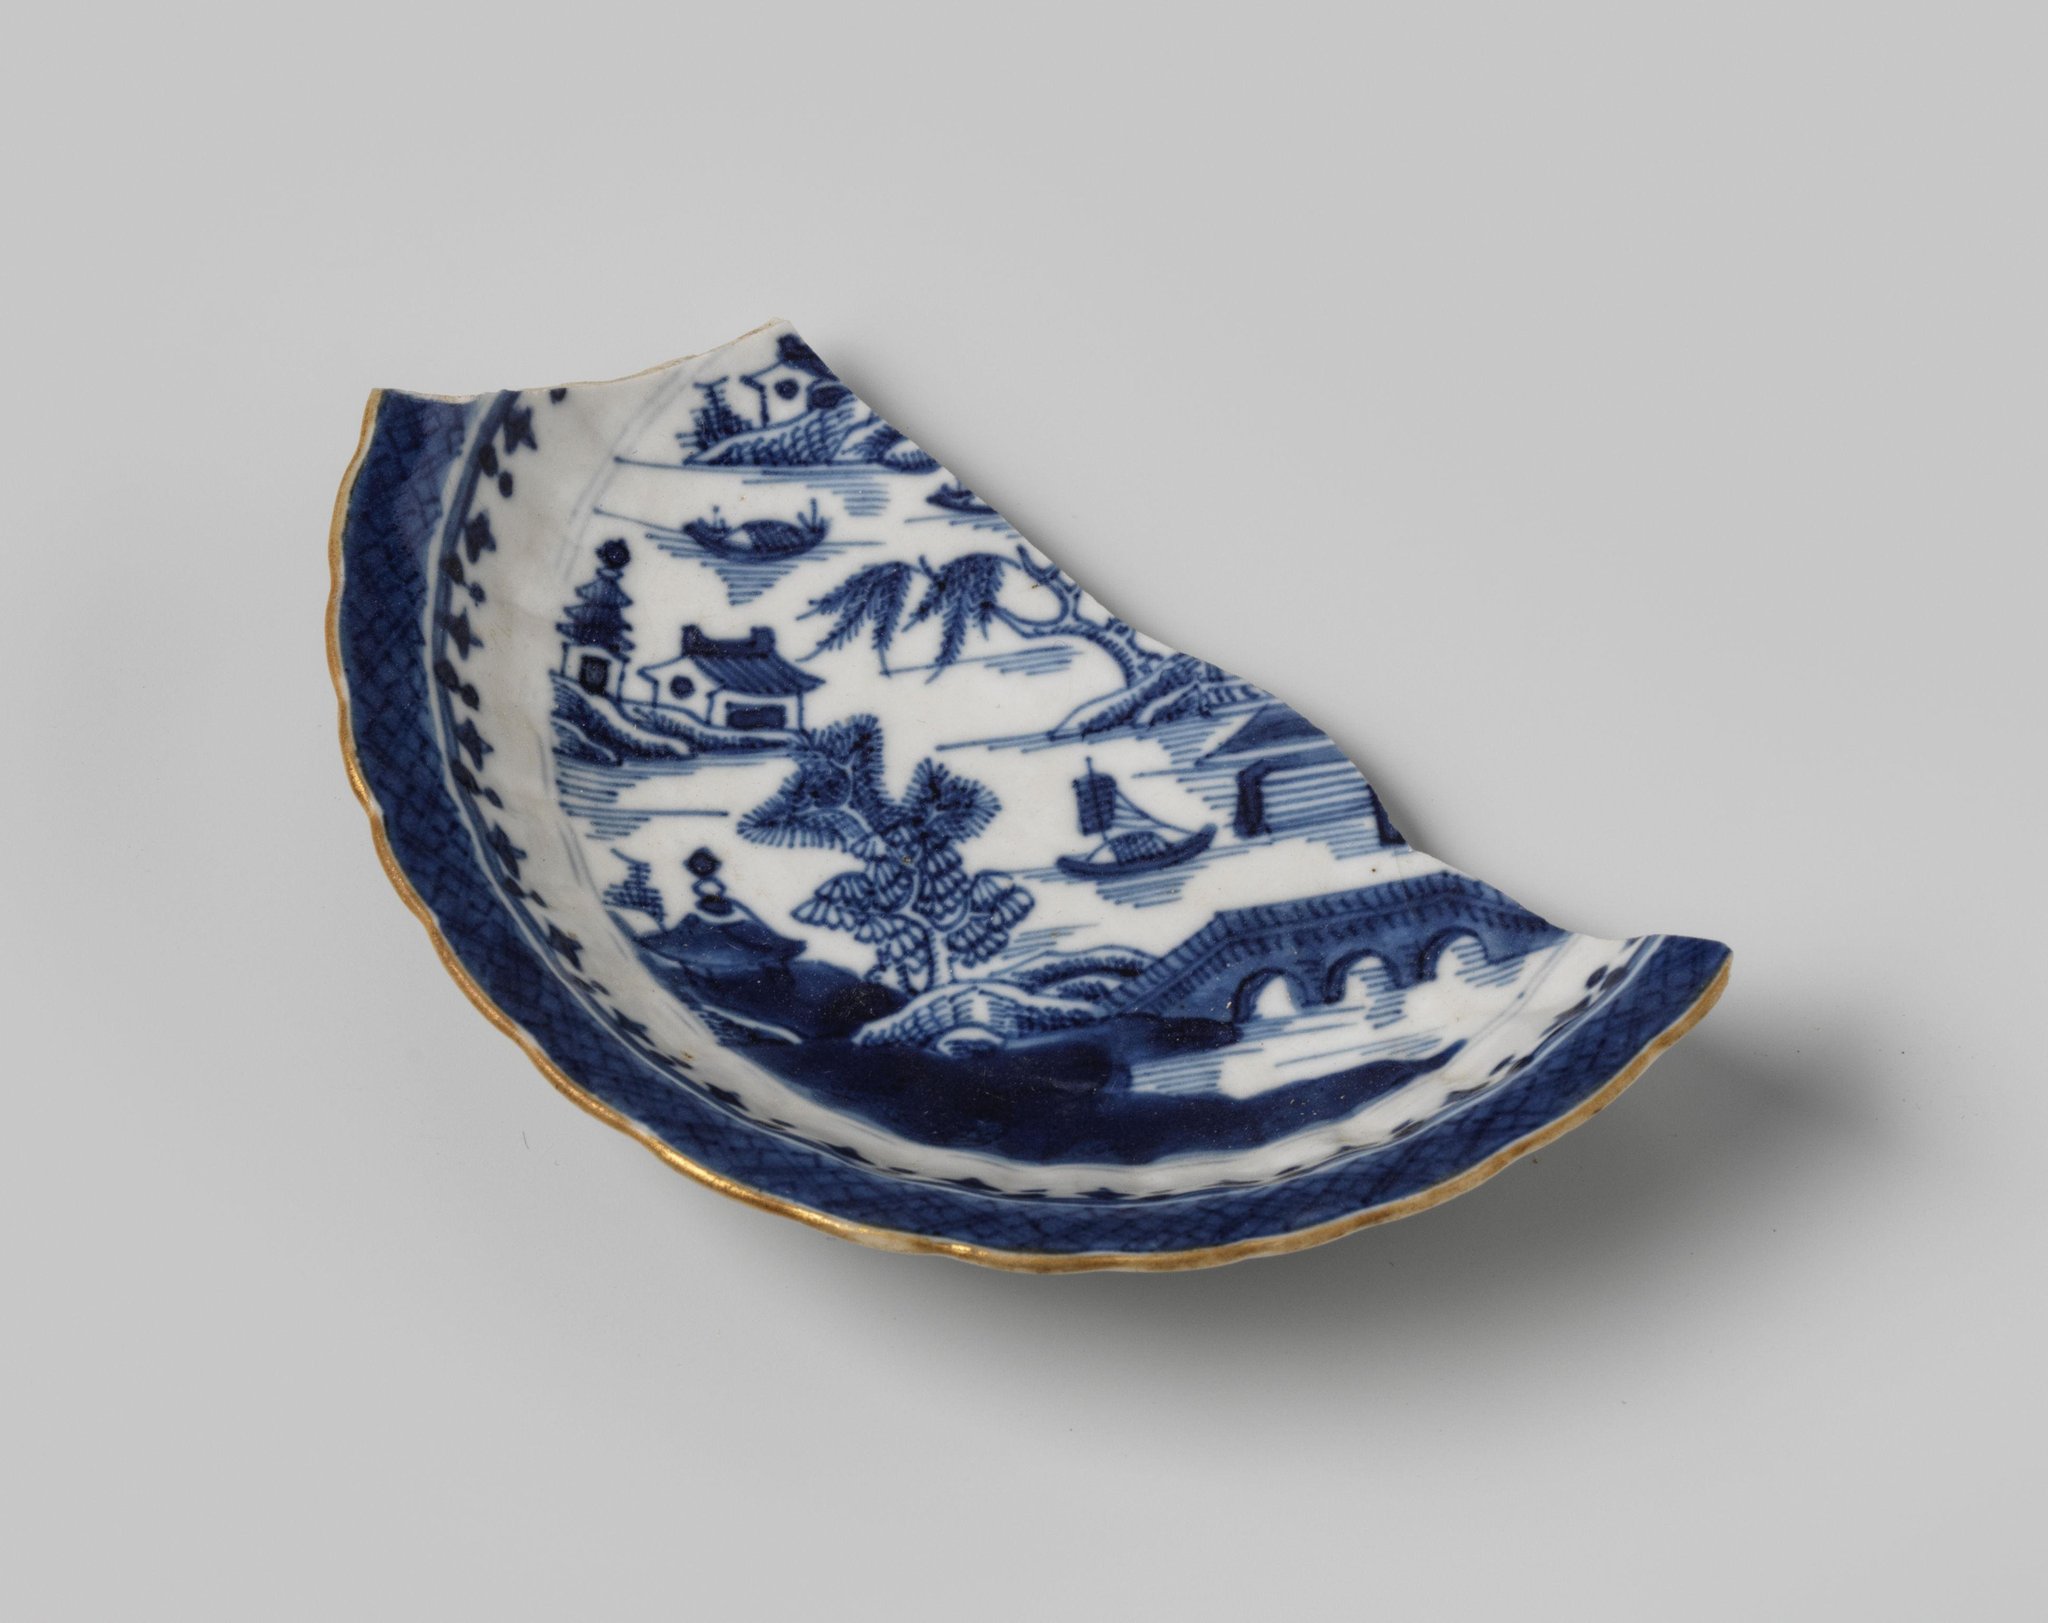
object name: plate dish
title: Bord, gevonden bij V.O.C.-schip Witte Leeuw, mogelijk afkomstig van Zeelelie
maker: Anonymous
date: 1775-1800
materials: porcelain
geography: jingdezhen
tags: verenigde oostindische compagnie, sint-helena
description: Bord gevonden bij V.O.C.-schip de 'Witte Leeuw', 45% aanwezig. Nanking-ceramiek bord. Dit object is 18e-eeuws en kan dus niet van de vracht van de Witte Leeuw zijn. Onduidelijk is of het object van de site komt of dat het later is vermengd, mogelijk met materiaal van de Zeelelie.